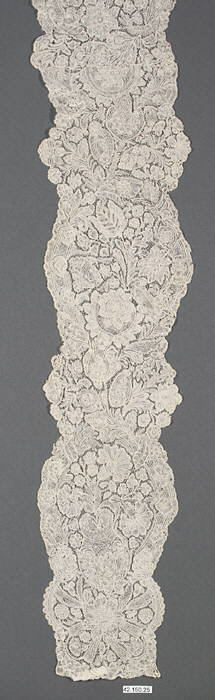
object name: lappet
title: Pair of lappets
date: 1701-1750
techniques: lace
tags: flowers